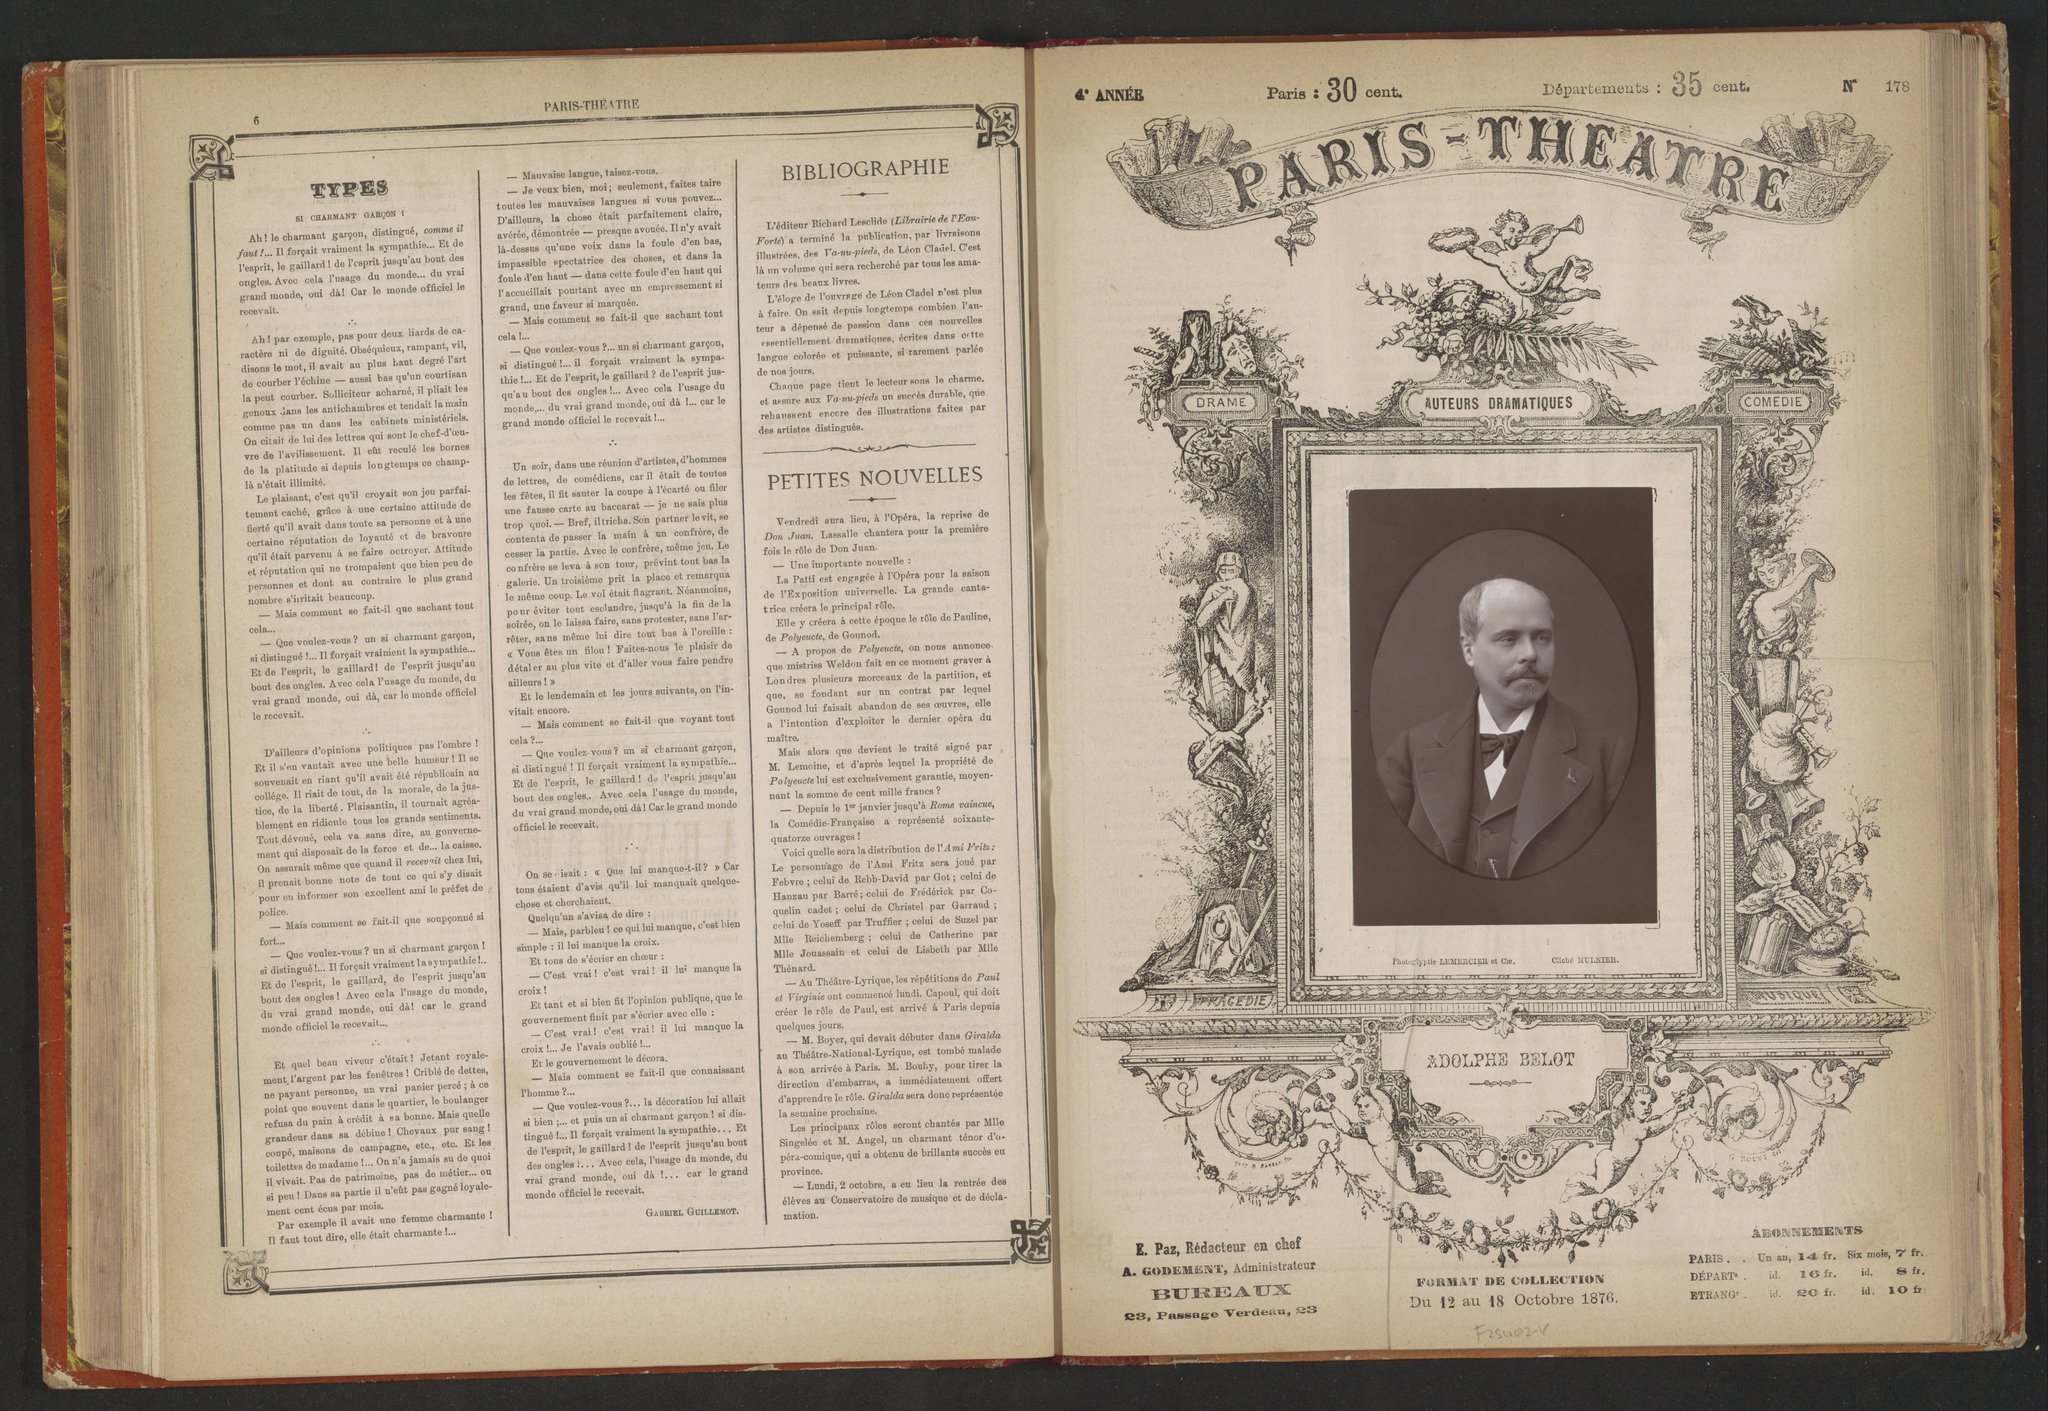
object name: page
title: Portret van Adolphe Belot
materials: paper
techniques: woodburytype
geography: france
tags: writer, poet, author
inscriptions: number: ‘No 178’, inscription: ‘Du 12 au 18 Octobre 1876.’